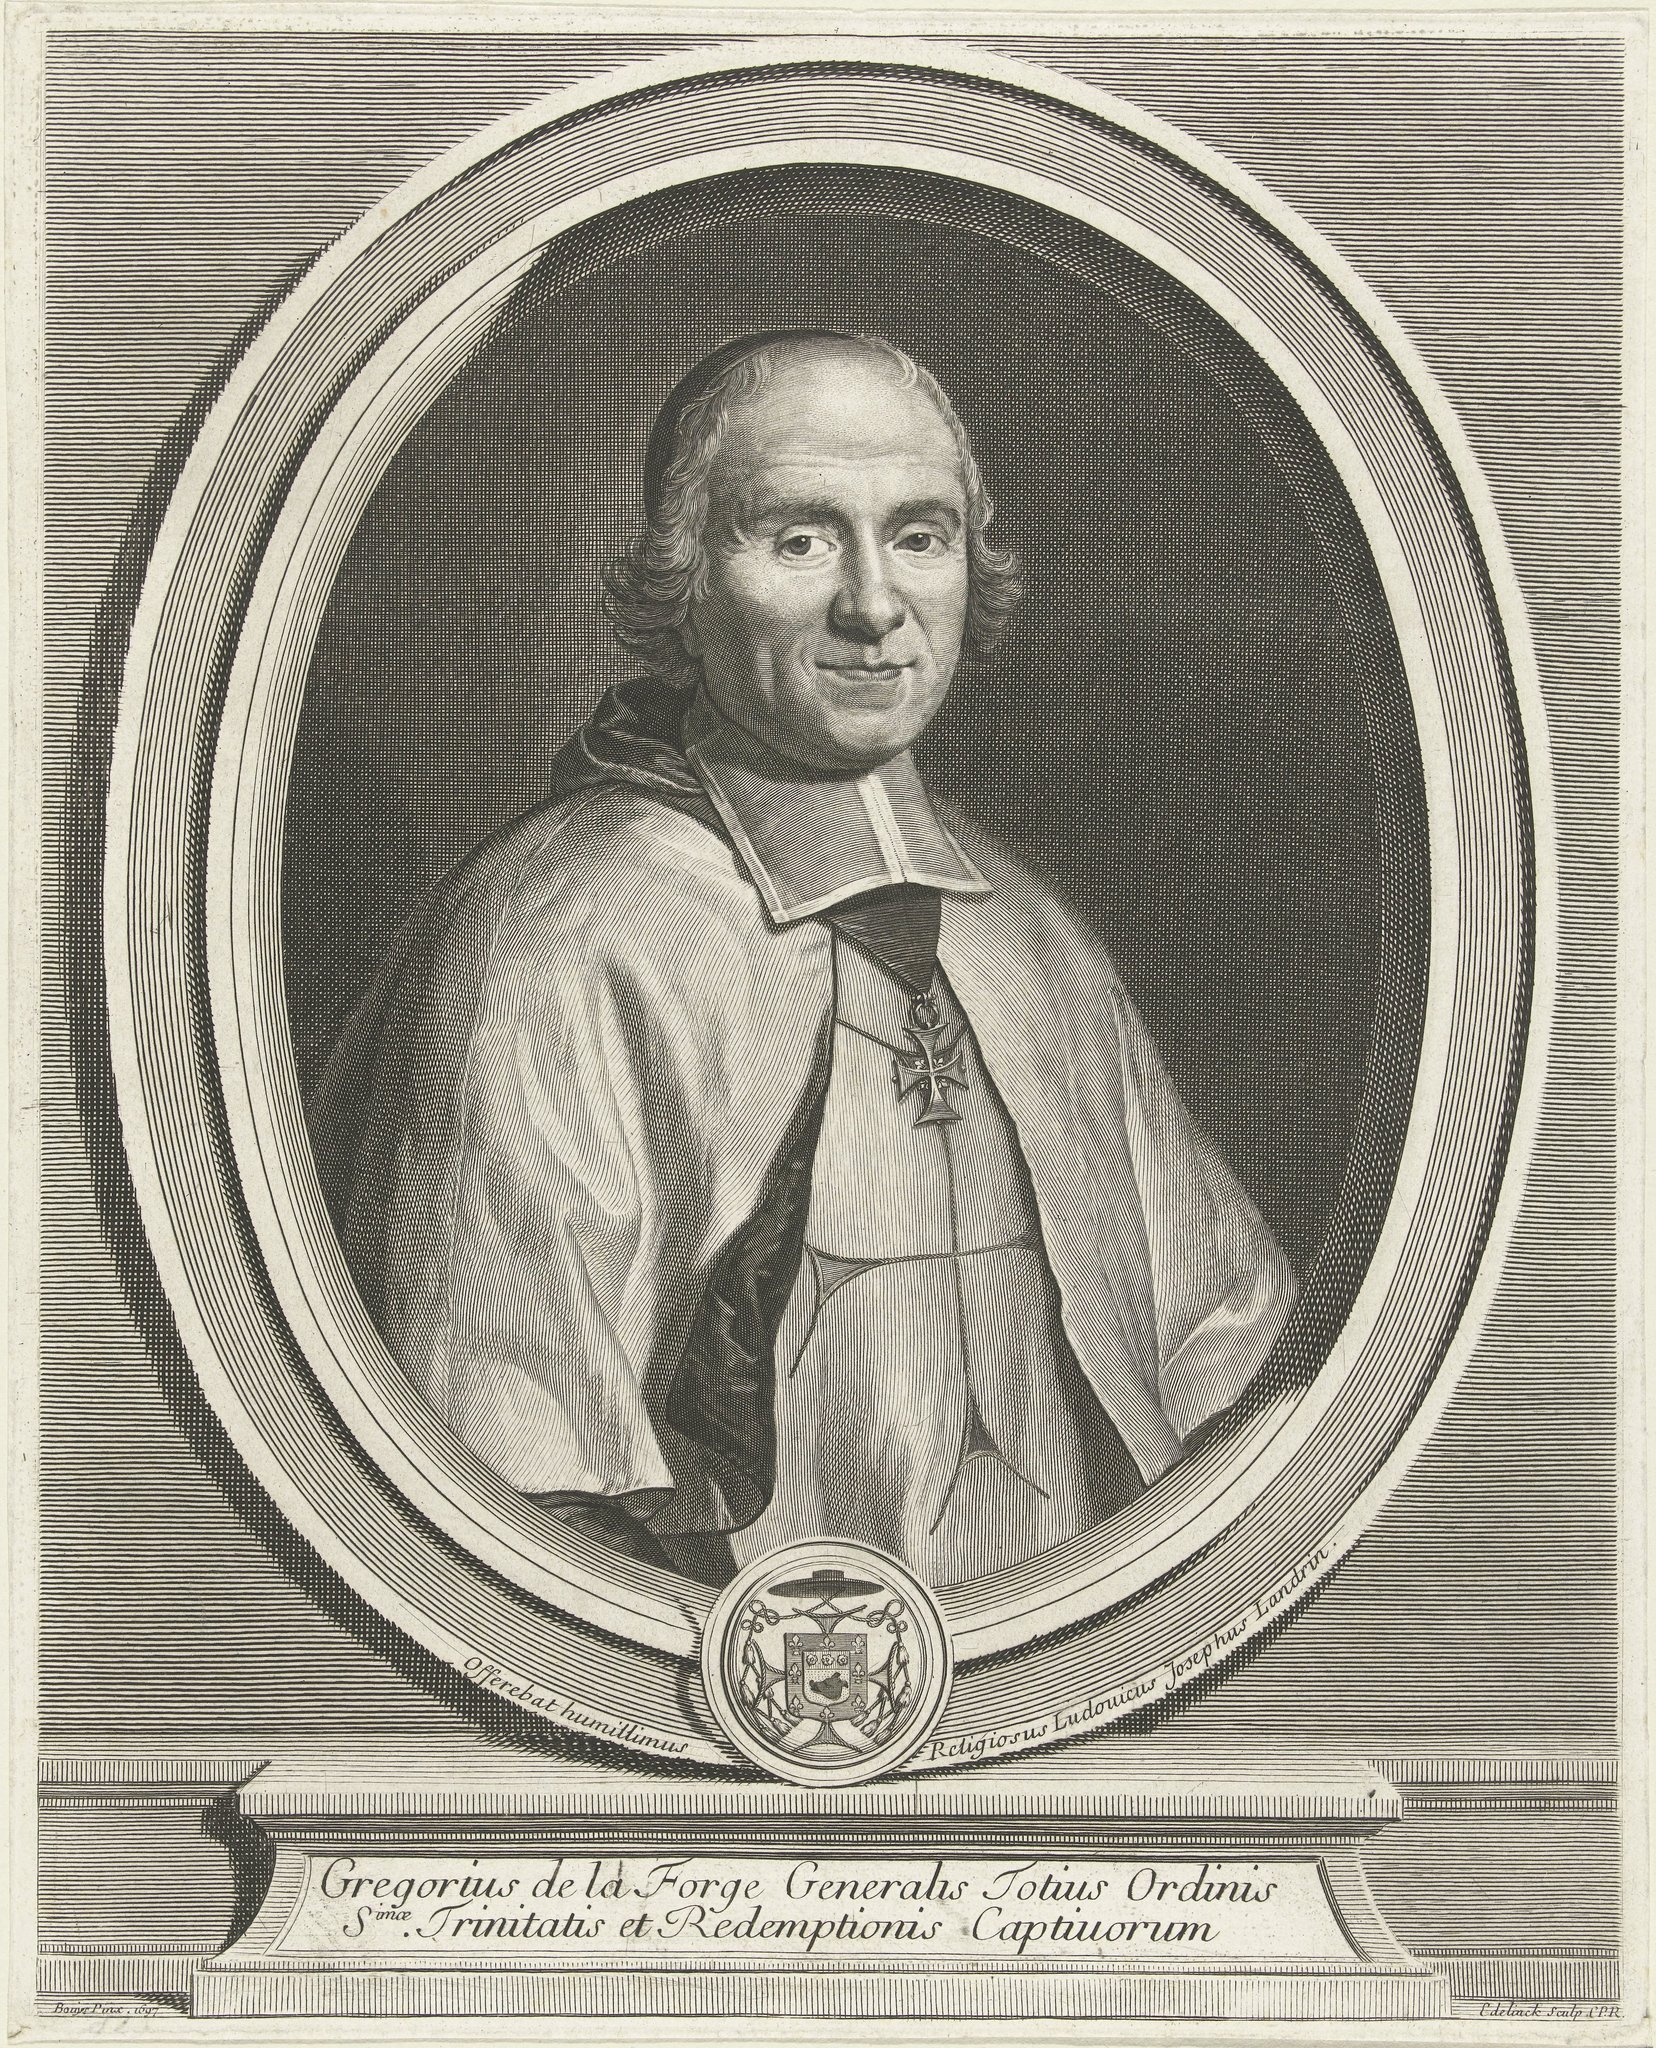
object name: print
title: Portret van Grégoire de la Forge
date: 1697-1707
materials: paper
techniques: engraving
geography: france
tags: grégoire de la forge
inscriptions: collector's mark: Lugt 240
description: Portret van Grégoire de la Forge, lid van de katholieke bedelorde der Trinitariërs, afgebeeld in ovale omlijsting met wapen, waaronder een console met twee regels Latijnse tekst.